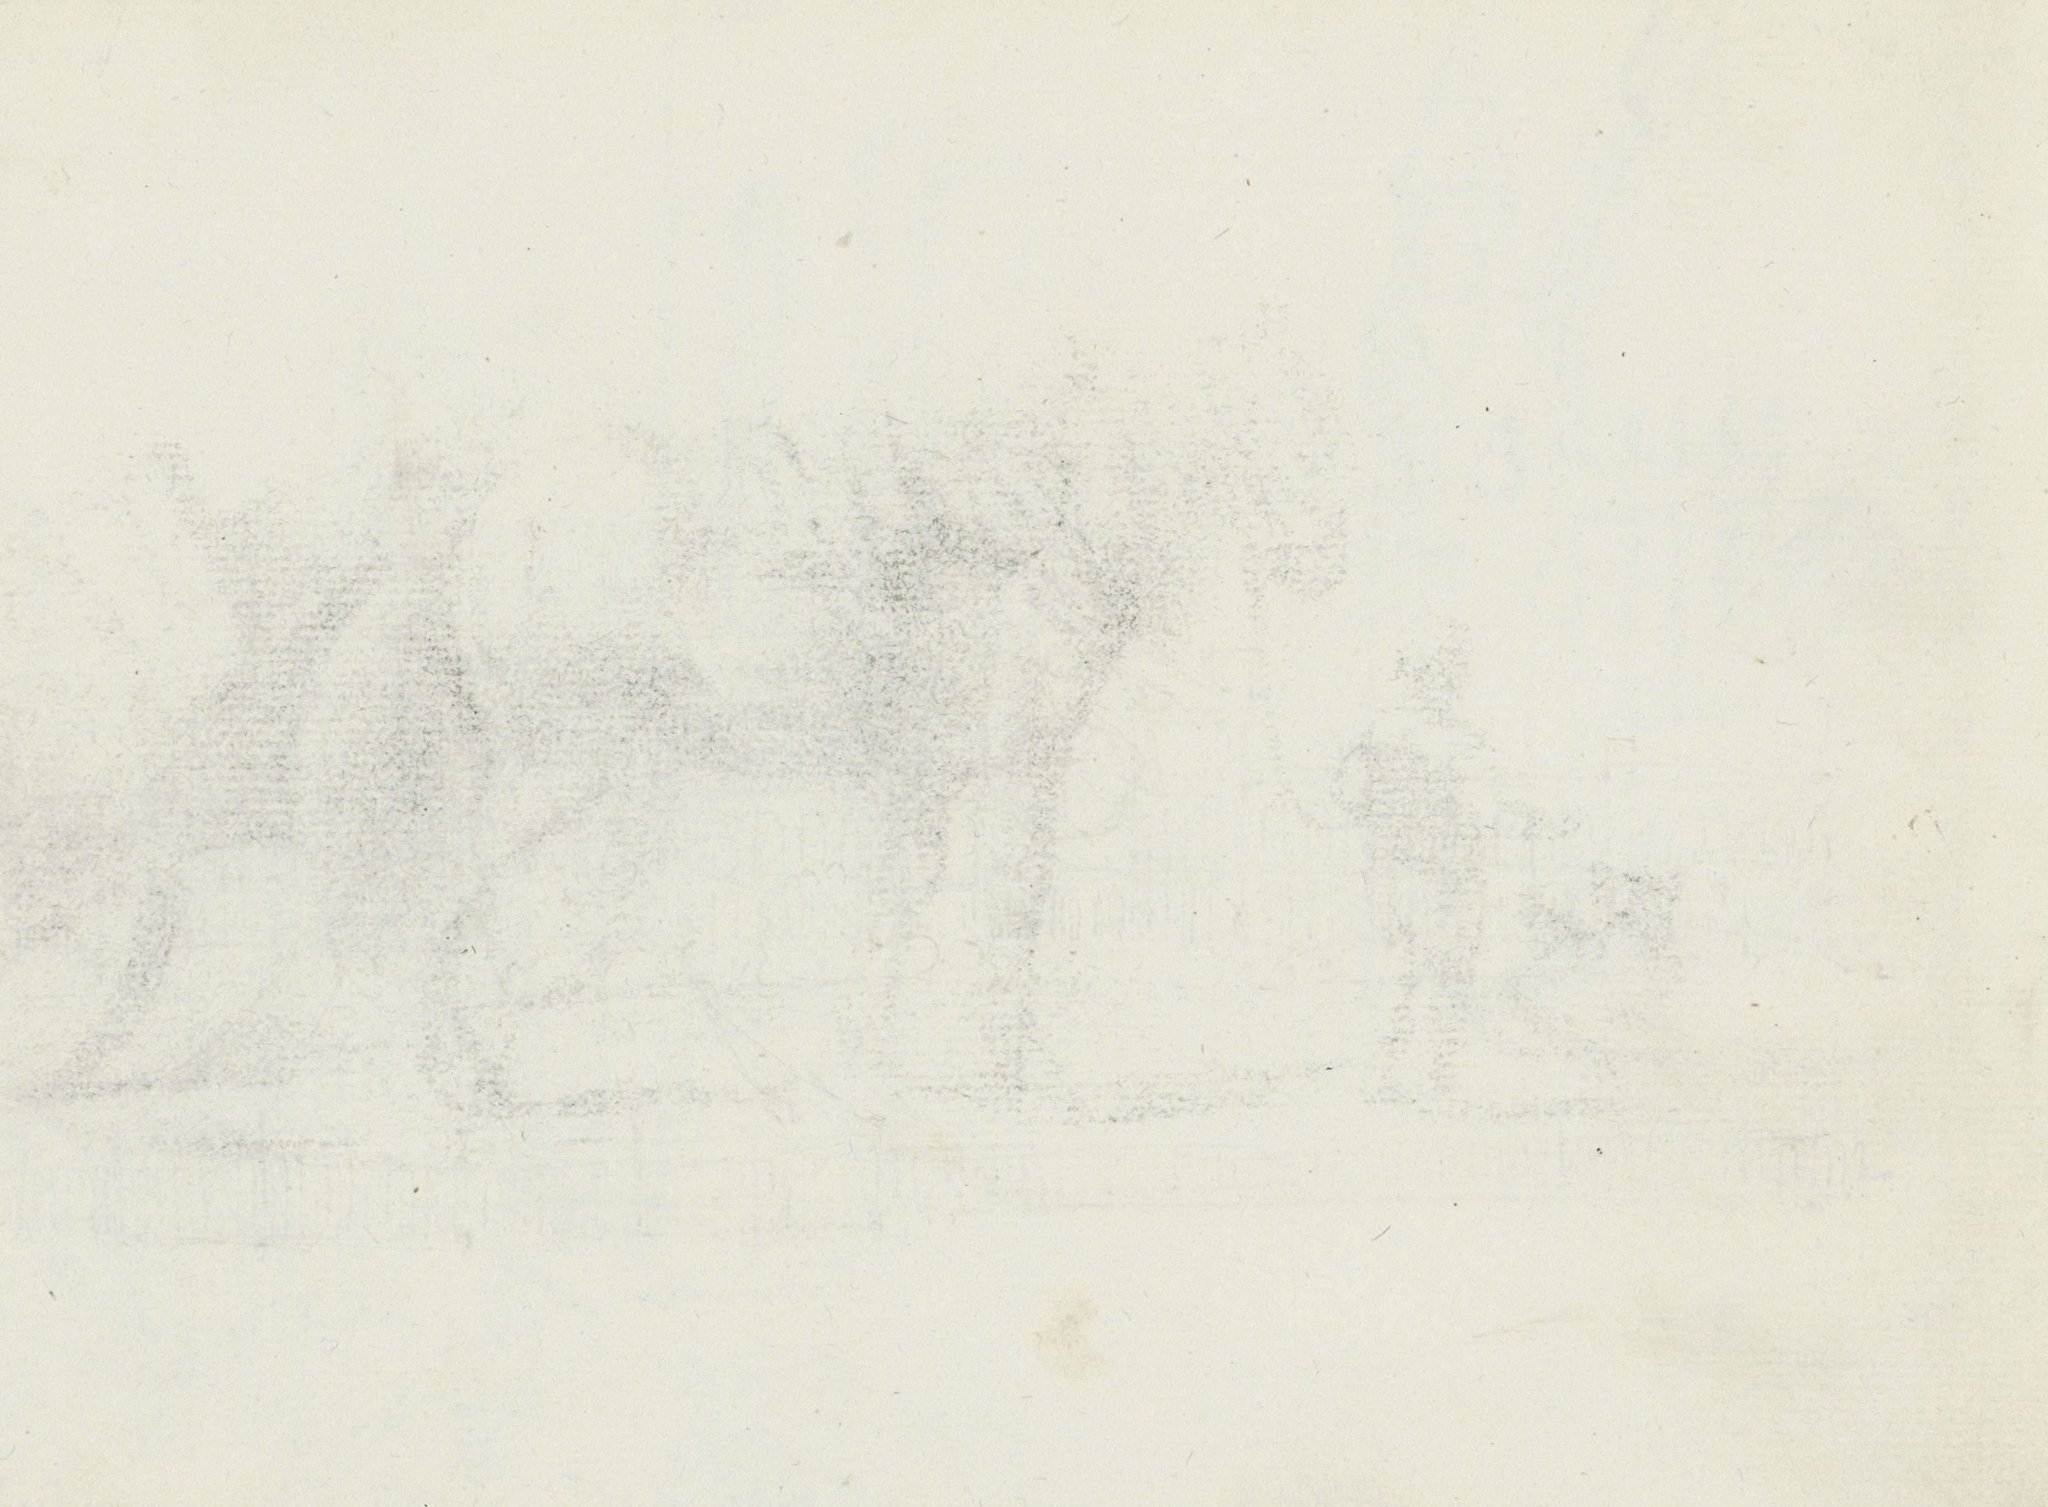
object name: sketchbook leaf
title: Abklatsch van de potloodtekening op blad 19 recto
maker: willem koekkoek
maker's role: draughtsman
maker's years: 1839-1895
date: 1849-1895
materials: paper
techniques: printmaking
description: Pagina 18 verso uit een schetsboek met 26 bladen.